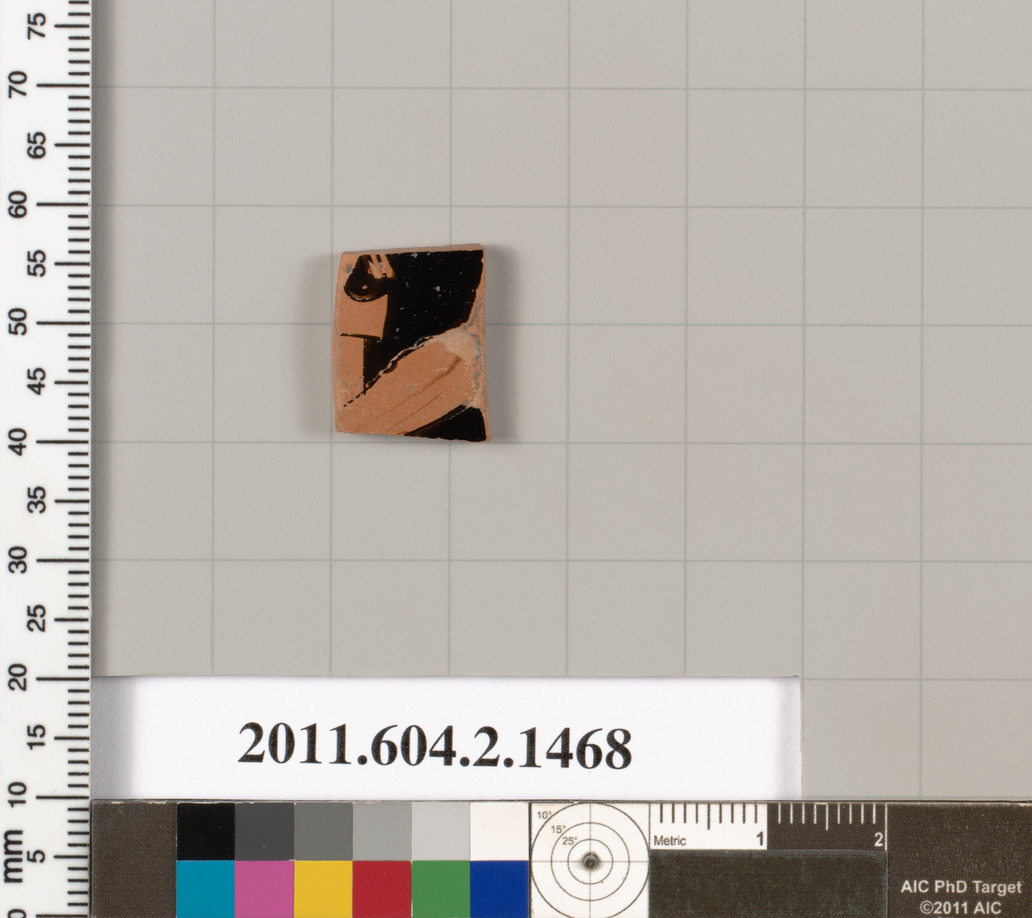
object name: skyphos fragment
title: Terracotta fragment of a skyphos (deep drinking cup)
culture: greek, attic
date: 460-440 BCE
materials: terracotta